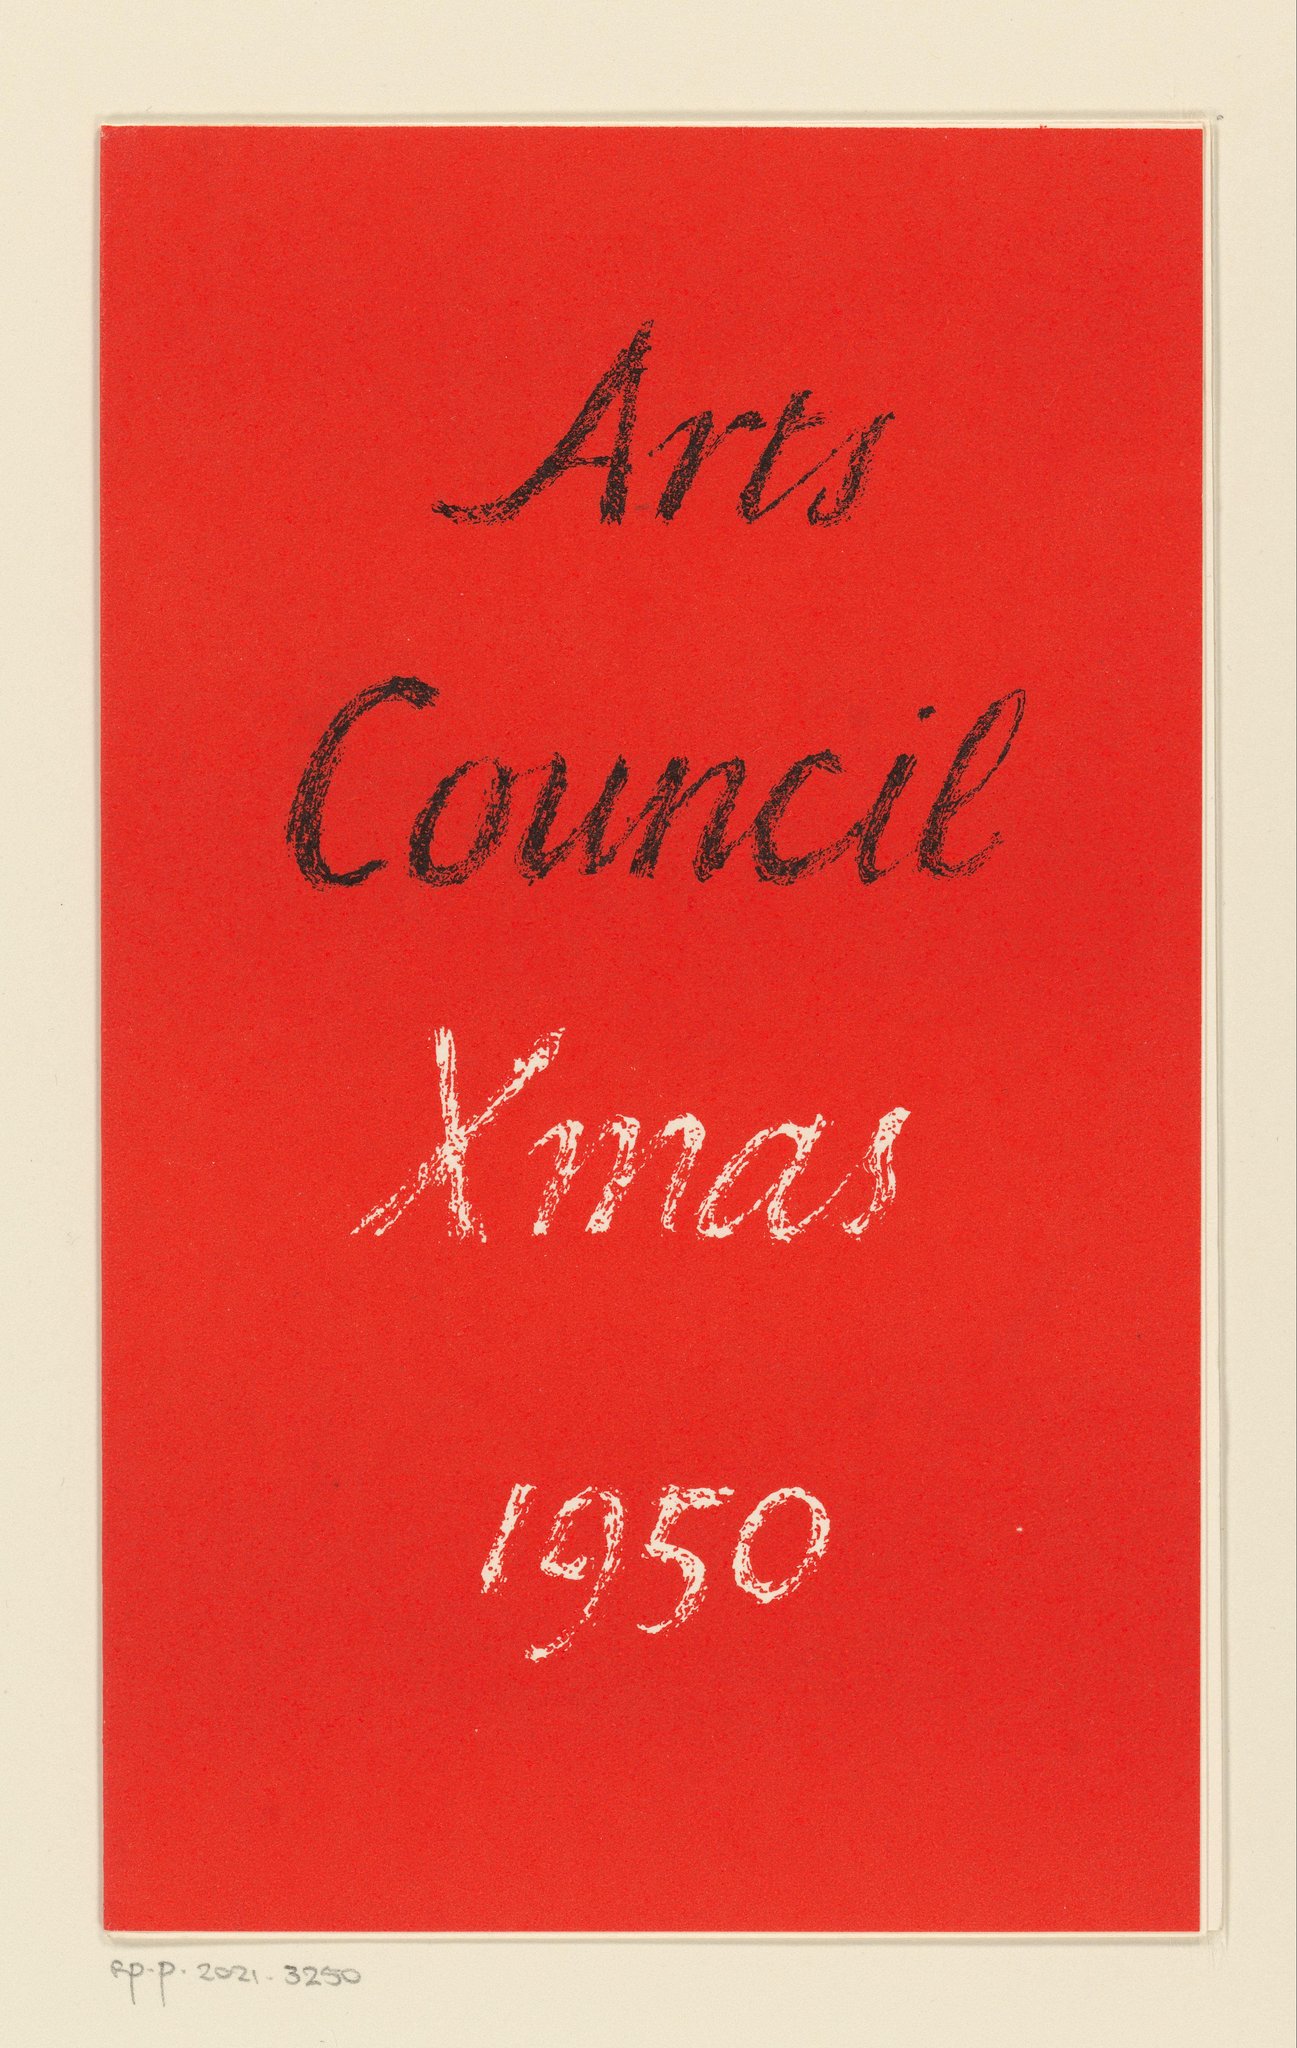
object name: christmas card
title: Kerst- en nieuwjaarswens voor 1950-1951 van The Arts Council of Great Britain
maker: Anonymous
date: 1950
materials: paper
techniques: lithograph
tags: large group of musicians, orchestra, christmas card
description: Buitenzijde rood met zwarte en witte tekst ('Arts Council Xmas 1950') en binnenin een afbeelding van een orkest met strijkers en blazers, en de tekst: 'With best wishes for Christmas 1950 and the New Year'.